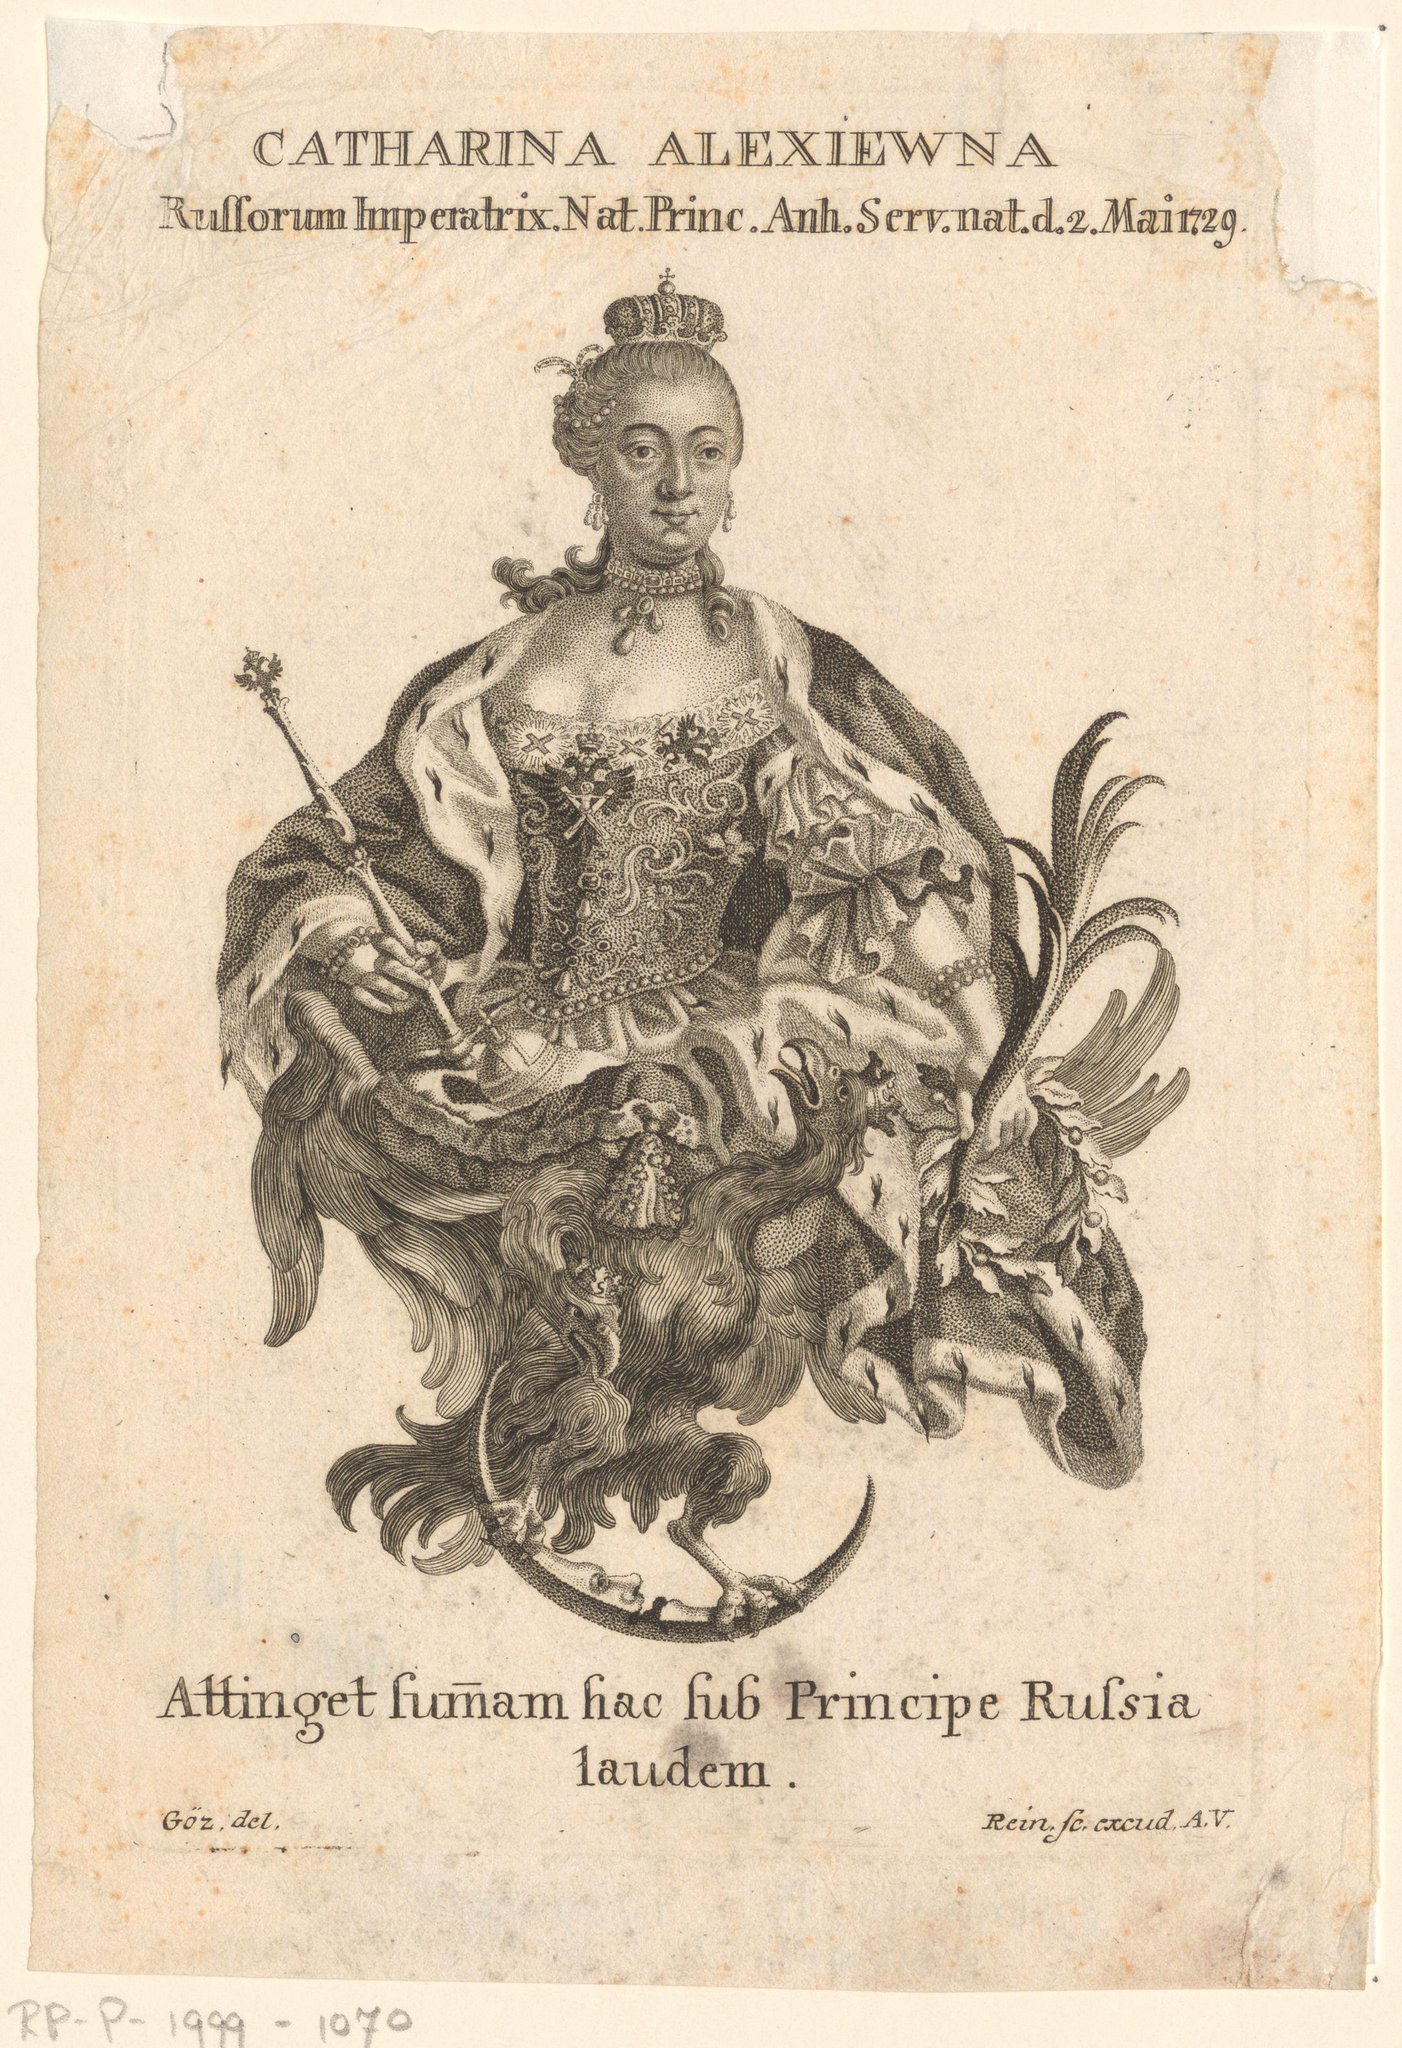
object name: print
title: Portret van Catharina de Grote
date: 1762-1785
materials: paper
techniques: engraving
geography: augsburg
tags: catharina de grote, historical persons - bb - woman, emperor - bb - female ruler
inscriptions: collector's mark: Lugt 2228, collector's mark: Lugt 2760